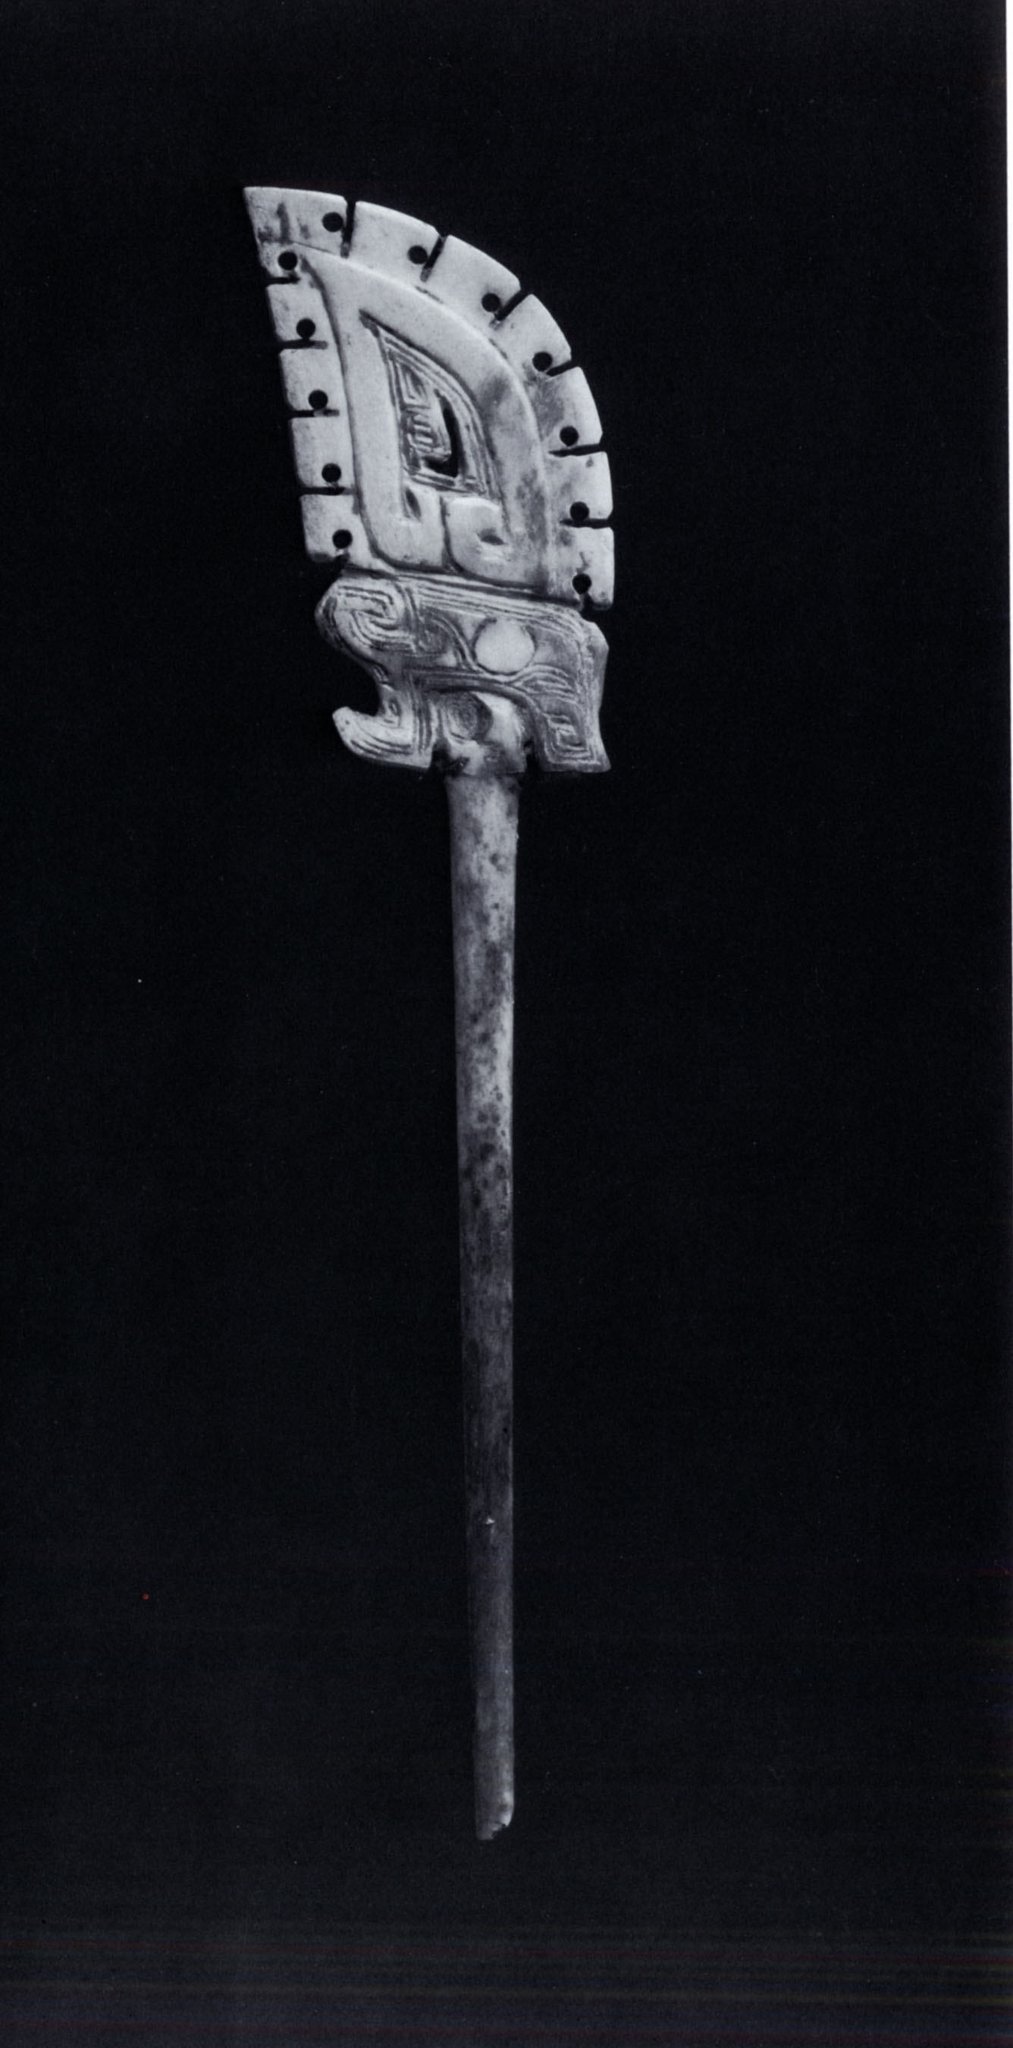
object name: hairpin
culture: chinese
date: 1300-1001 BCE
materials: bone